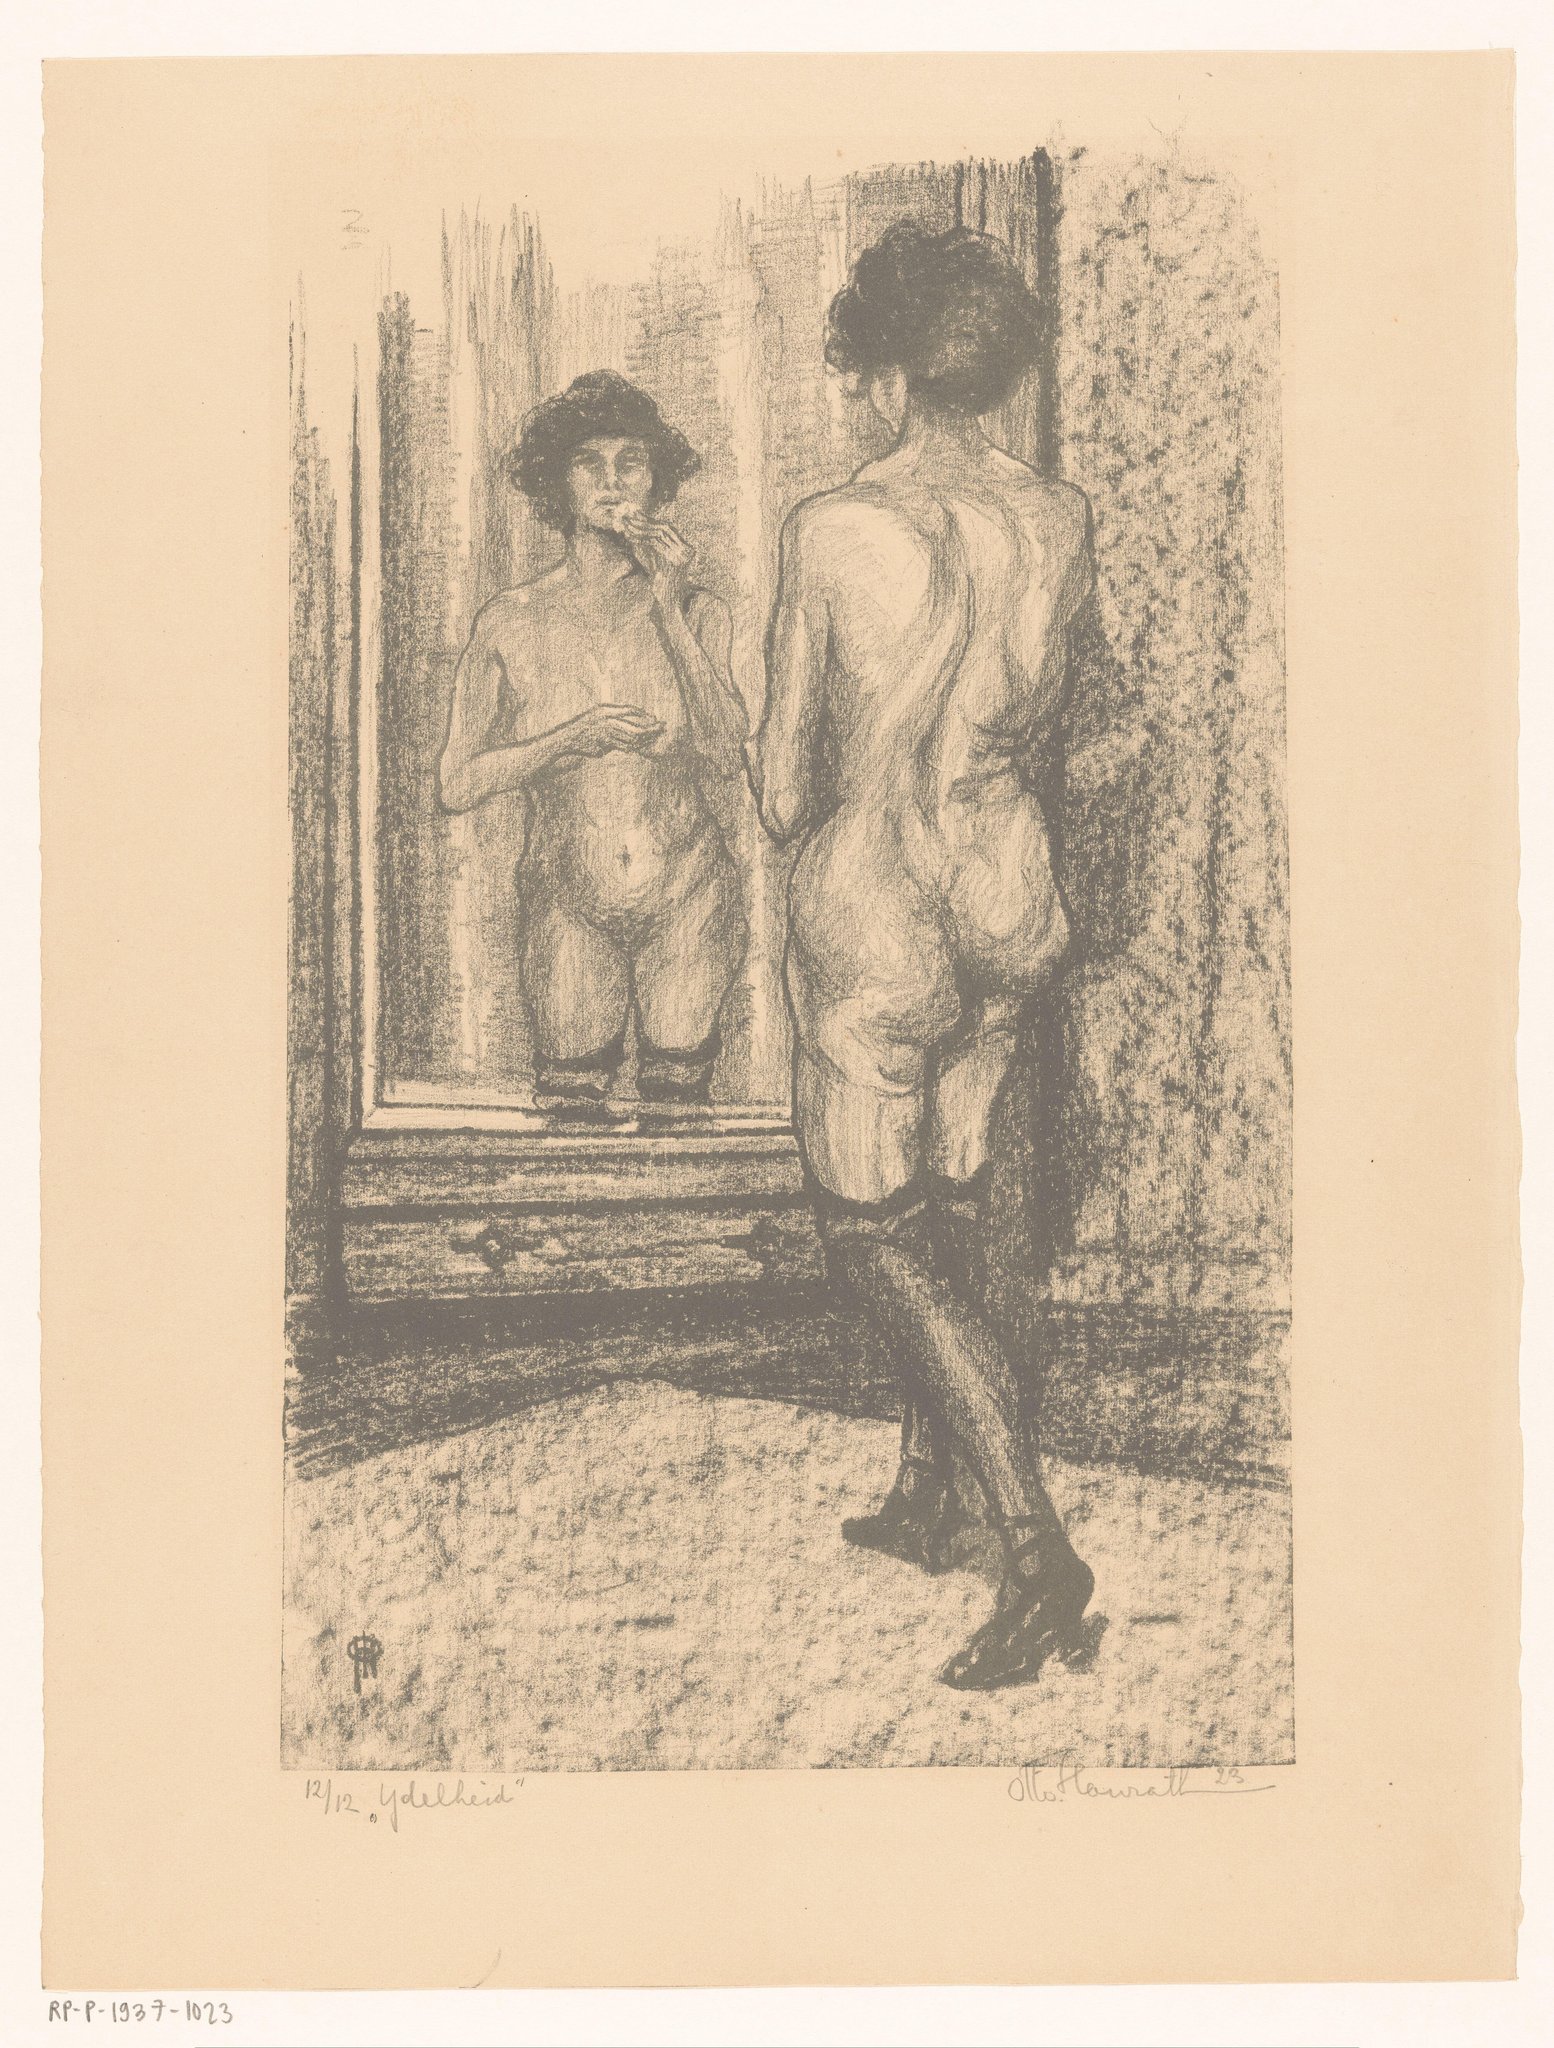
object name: print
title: IJdelheid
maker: otto hanrath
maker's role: print maker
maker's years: 1882-1944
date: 1923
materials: paper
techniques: lithograph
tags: mirror, woman (showing herself) undressed, quasi-nude, (woman) looking in a mirror ~ scene symbolizing 'vanitas'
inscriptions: collector's mark: Lugt 2228, collector's mark: Lugt 2760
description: Een halfnaakte vrouw, die kousen en pumps draagt, bekijkt zichzelf in een spiegel.